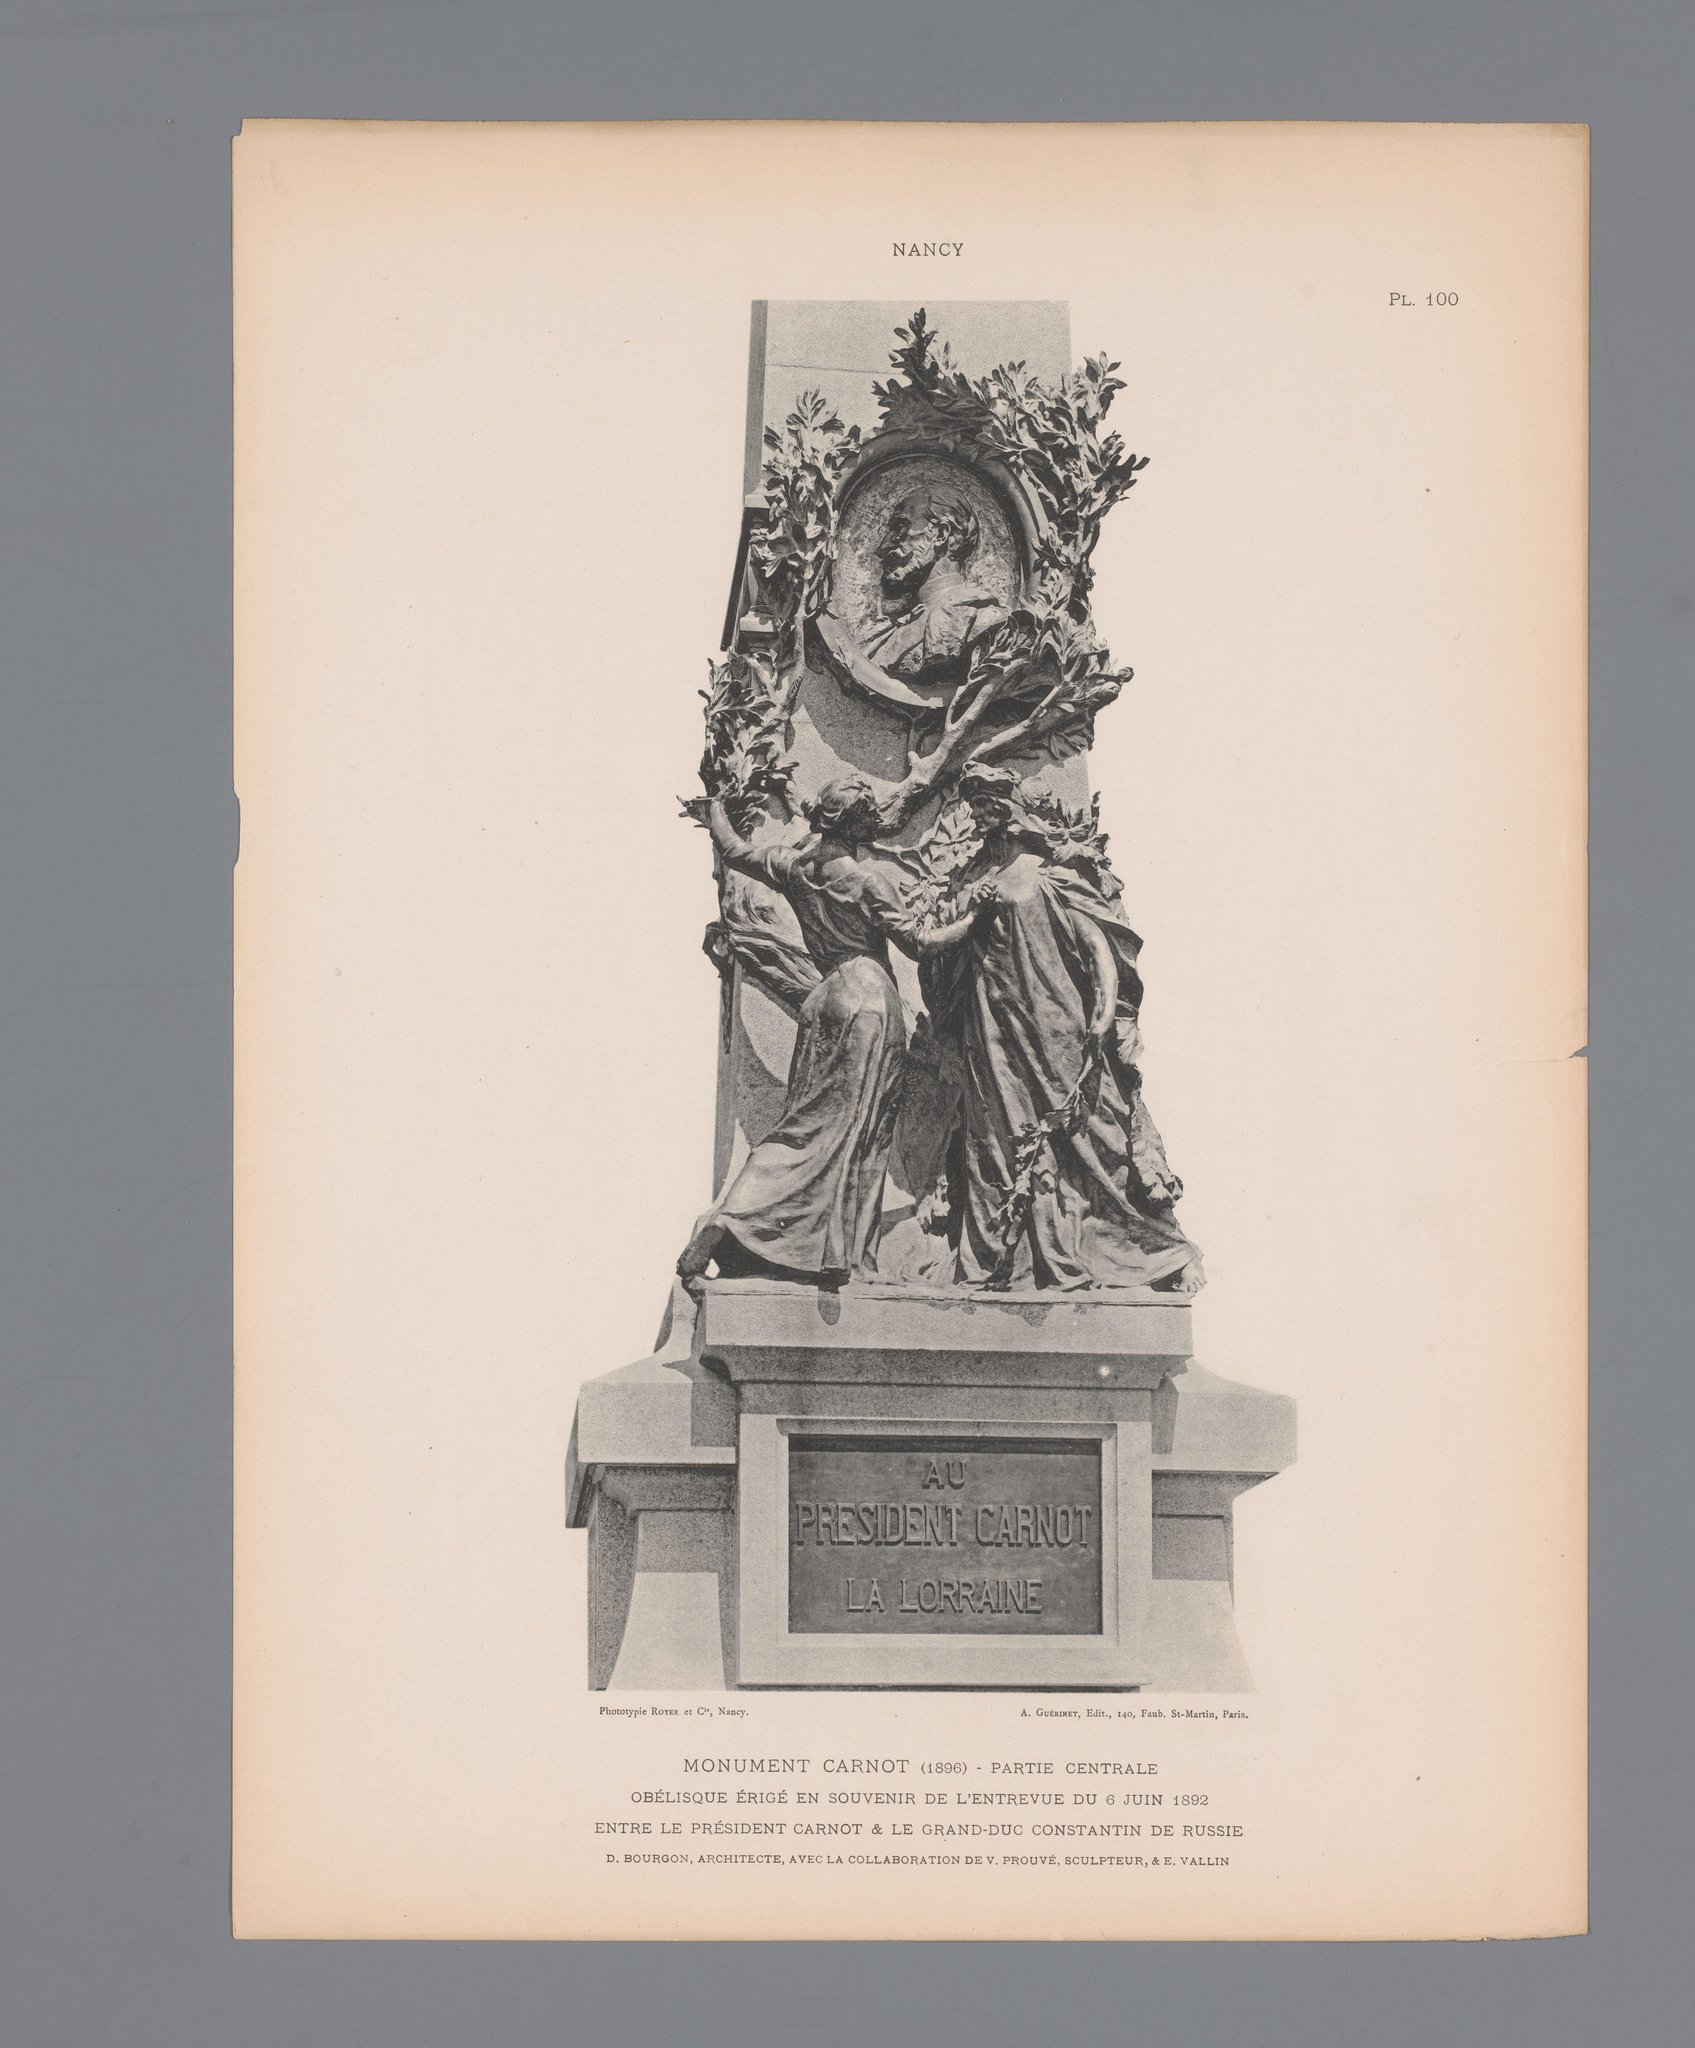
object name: photomechanical print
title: Detail van de obelisk van Nancy of het Carnot-monument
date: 1891-1896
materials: paper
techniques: photograph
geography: paris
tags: obelisk, needle, monument, statue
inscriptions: inscription: ‘Monument Carnot (1896) - partie centrale/ obélisque érigé en souvenir de l'entreuve du 6 juin 1892 (...)’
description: Deze prent maakt deel uit van een omslag met 103 prenten op 101 bladen en een titelblad.